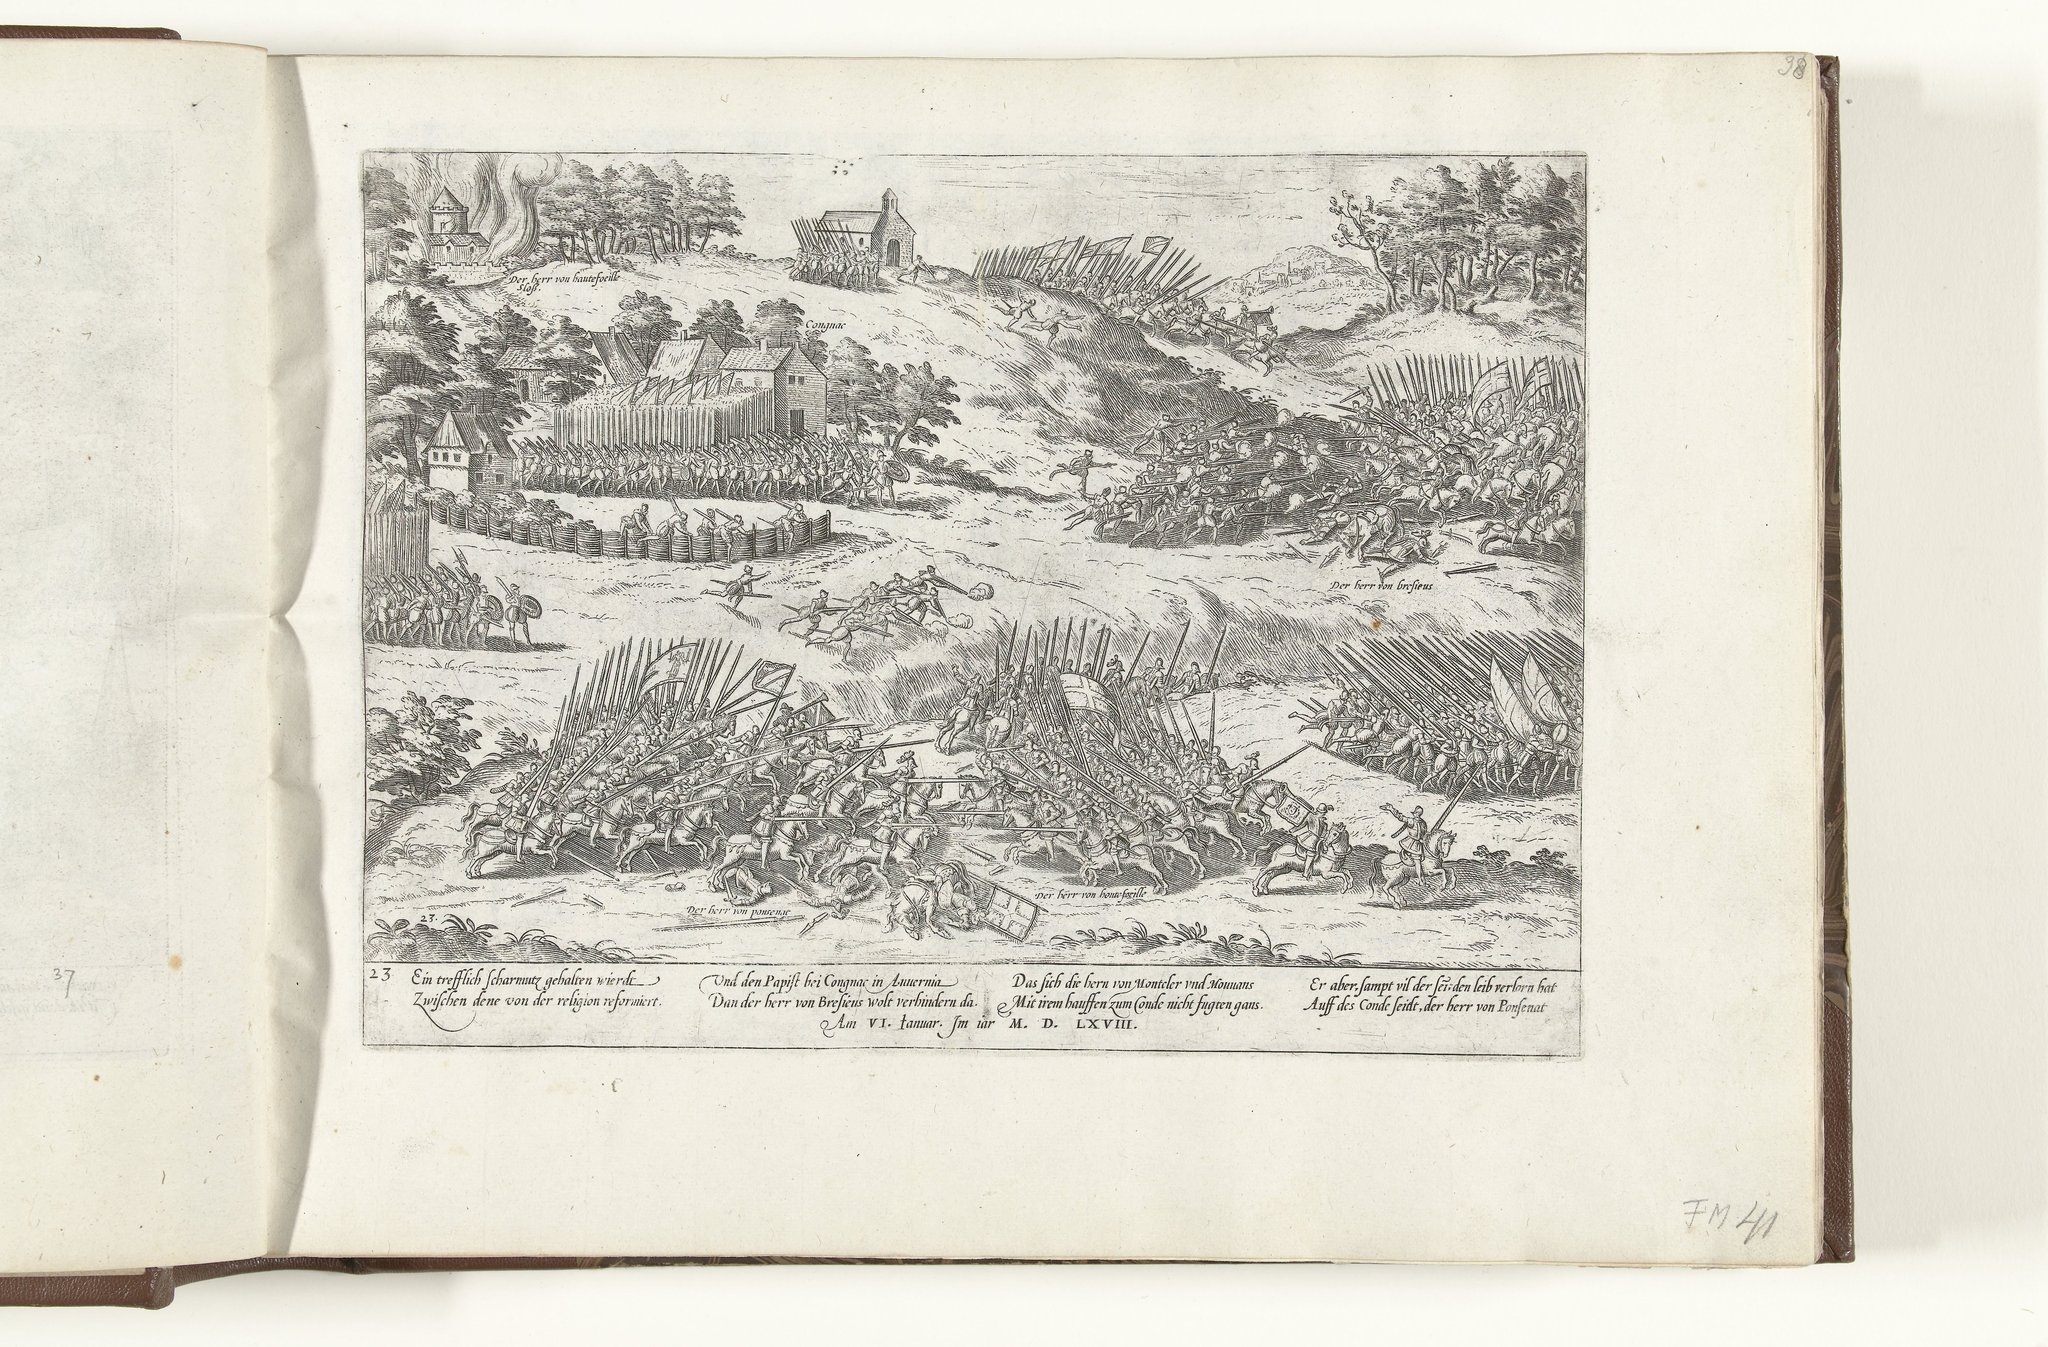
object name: print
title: Slag bij Cognac in de Auvergne, 1568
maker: frans hogenberg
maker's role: print maker, publisher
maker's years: 1538-1590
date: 1565-1573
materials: paper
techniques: etching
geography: cologne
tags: battle (+ land forces)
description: Gekopieerd naar de prent in: Jean Tortorel et Jacques Perrissin, Premier volume contenant quarante tableaux ou Histoires diverses qui sont memorables touchant les Guerres, Massacres et Troubles advenus en France en ces dernieres annees : le tout recueilly selon le tesmoignange de ceux qui y ont esté en personne et qui les ont veus : lesquels sont pourtraits à la vérité, Genève ca. 1570. Bibliotheek Rijksmuseum: 329 A 2, pl. 29.